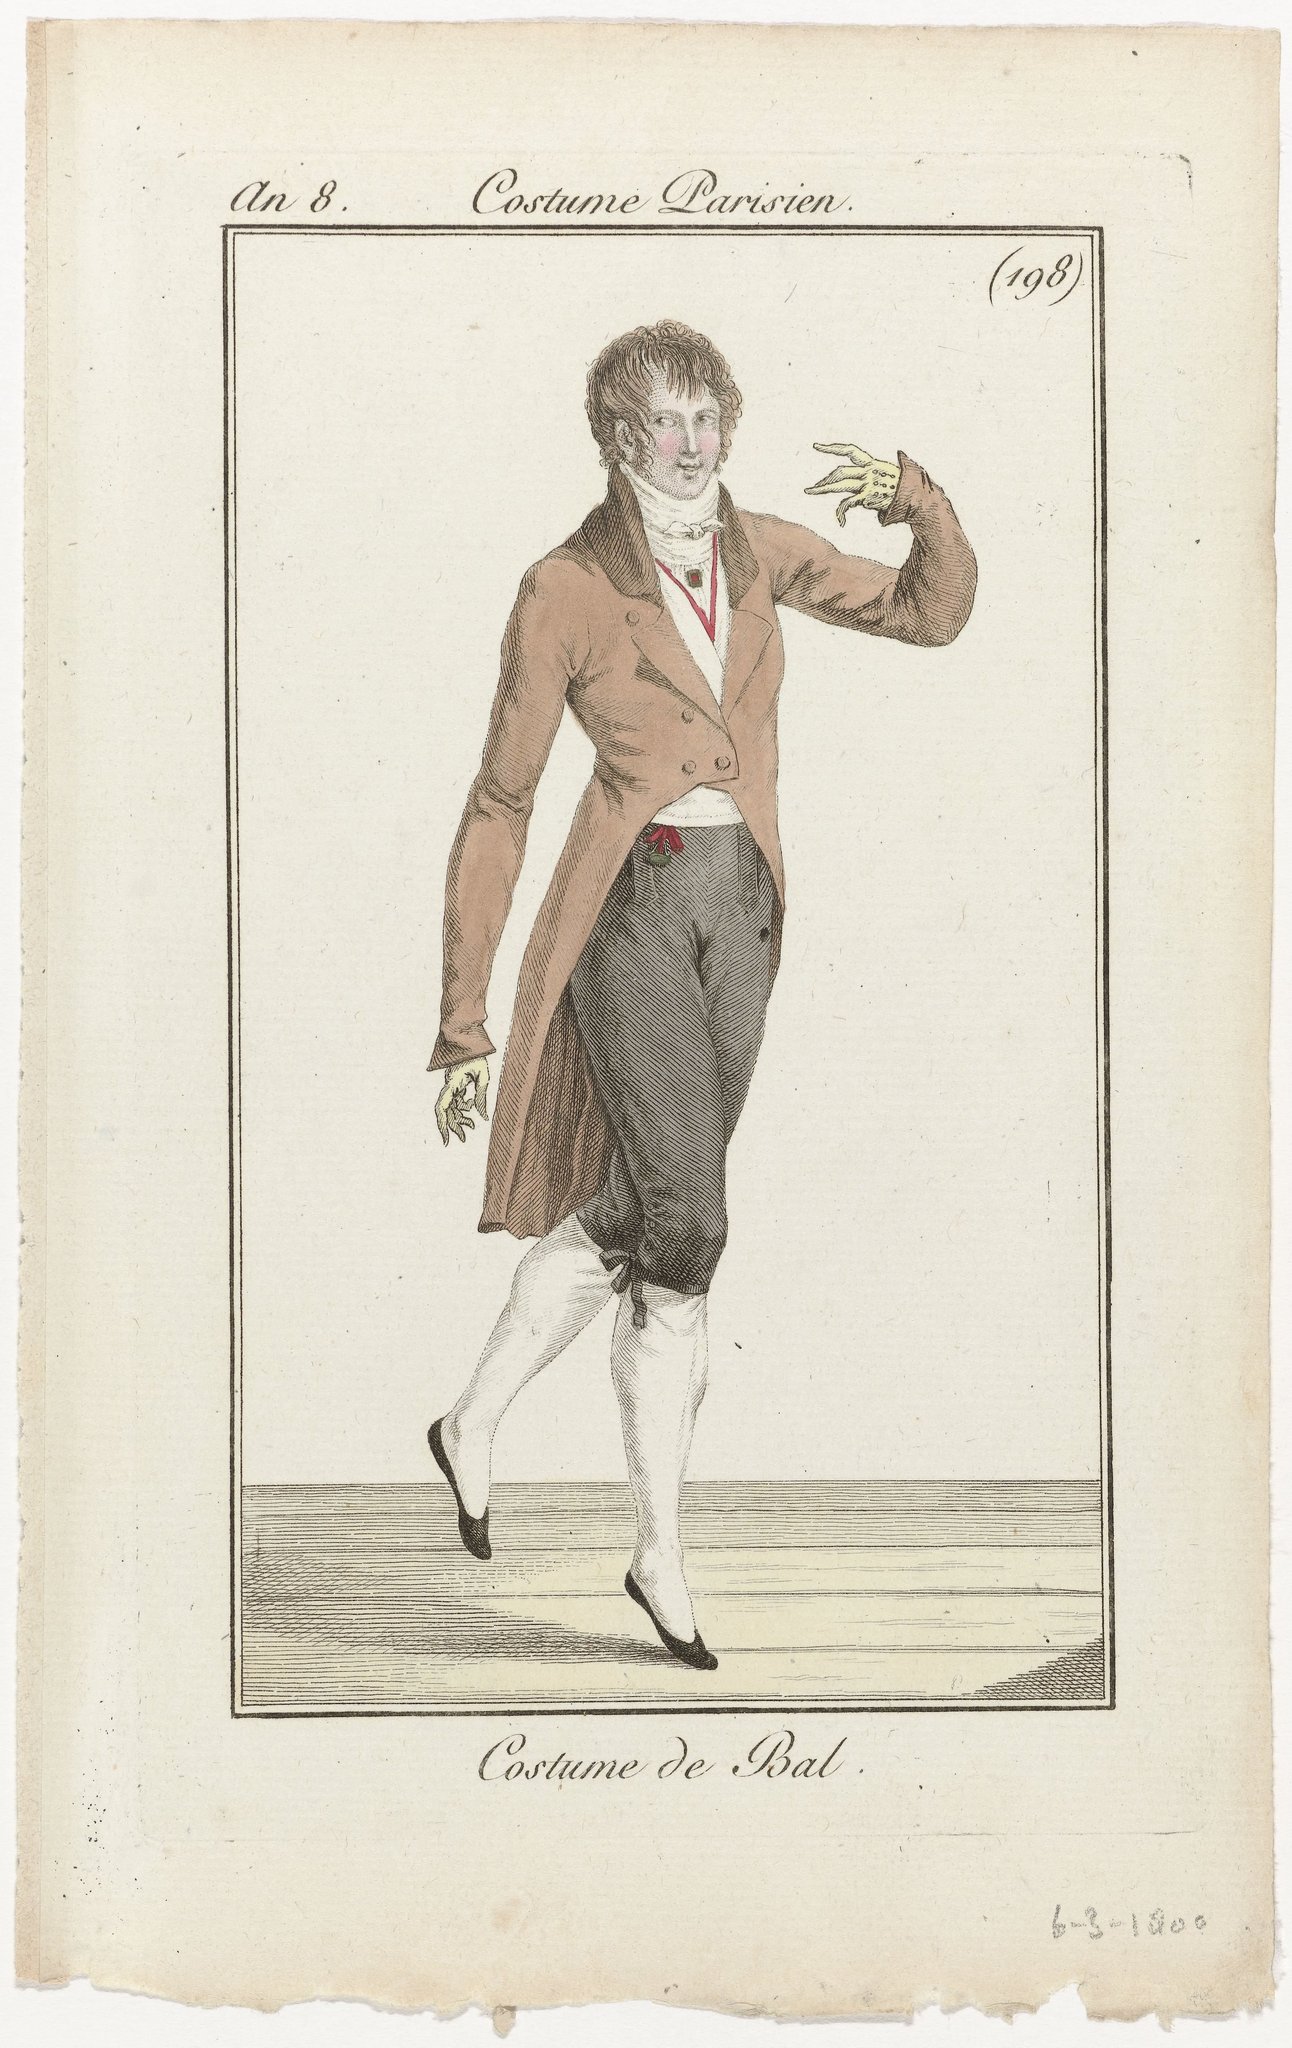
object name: fashion print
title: Journal des Dames et des Modes, Costume Parisien, 6 mars 1800, An 8, (198): Costume de Bal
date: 1800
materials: paper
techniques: engraving, hand coloring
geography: paris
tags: clothing for the upper part of the body (vest) (+ men's clothes), neck-gear ~ clothing (cravat) (+ men's clothes), coat (+ men's clothes), fibula, safety pin (+ men's clothes), fashion plates, gloves, mittens, etc. (+ women's clothes), shoes, sandals (+ men's clothes), trousers, breeches, etc. (breeches) (+ men's clothes), stockings, socks (+ men's clothes)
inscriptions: caption: ‘Costume de Bal.’, title: ‘Costume Parisien.’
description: Man in balkostuum, een danspas makend. Het kostuum bestaat uit een jas met twee rijen knopen, een vest en kniebroek. Hoge cravate, hemd en kousen. Accessoires: sierspeld, breloque met een groene steen (die kon worden gegraveerd) aan een strikje van een rood lint, dat om de hals hangt. Gele handschoenen, platte schoenen. De prent maakt deel uit van het modetijdschrift Journal des Dames et des Modes, uitgegeven door Pierre de la Mésangère, Parijs, 1797-1839.